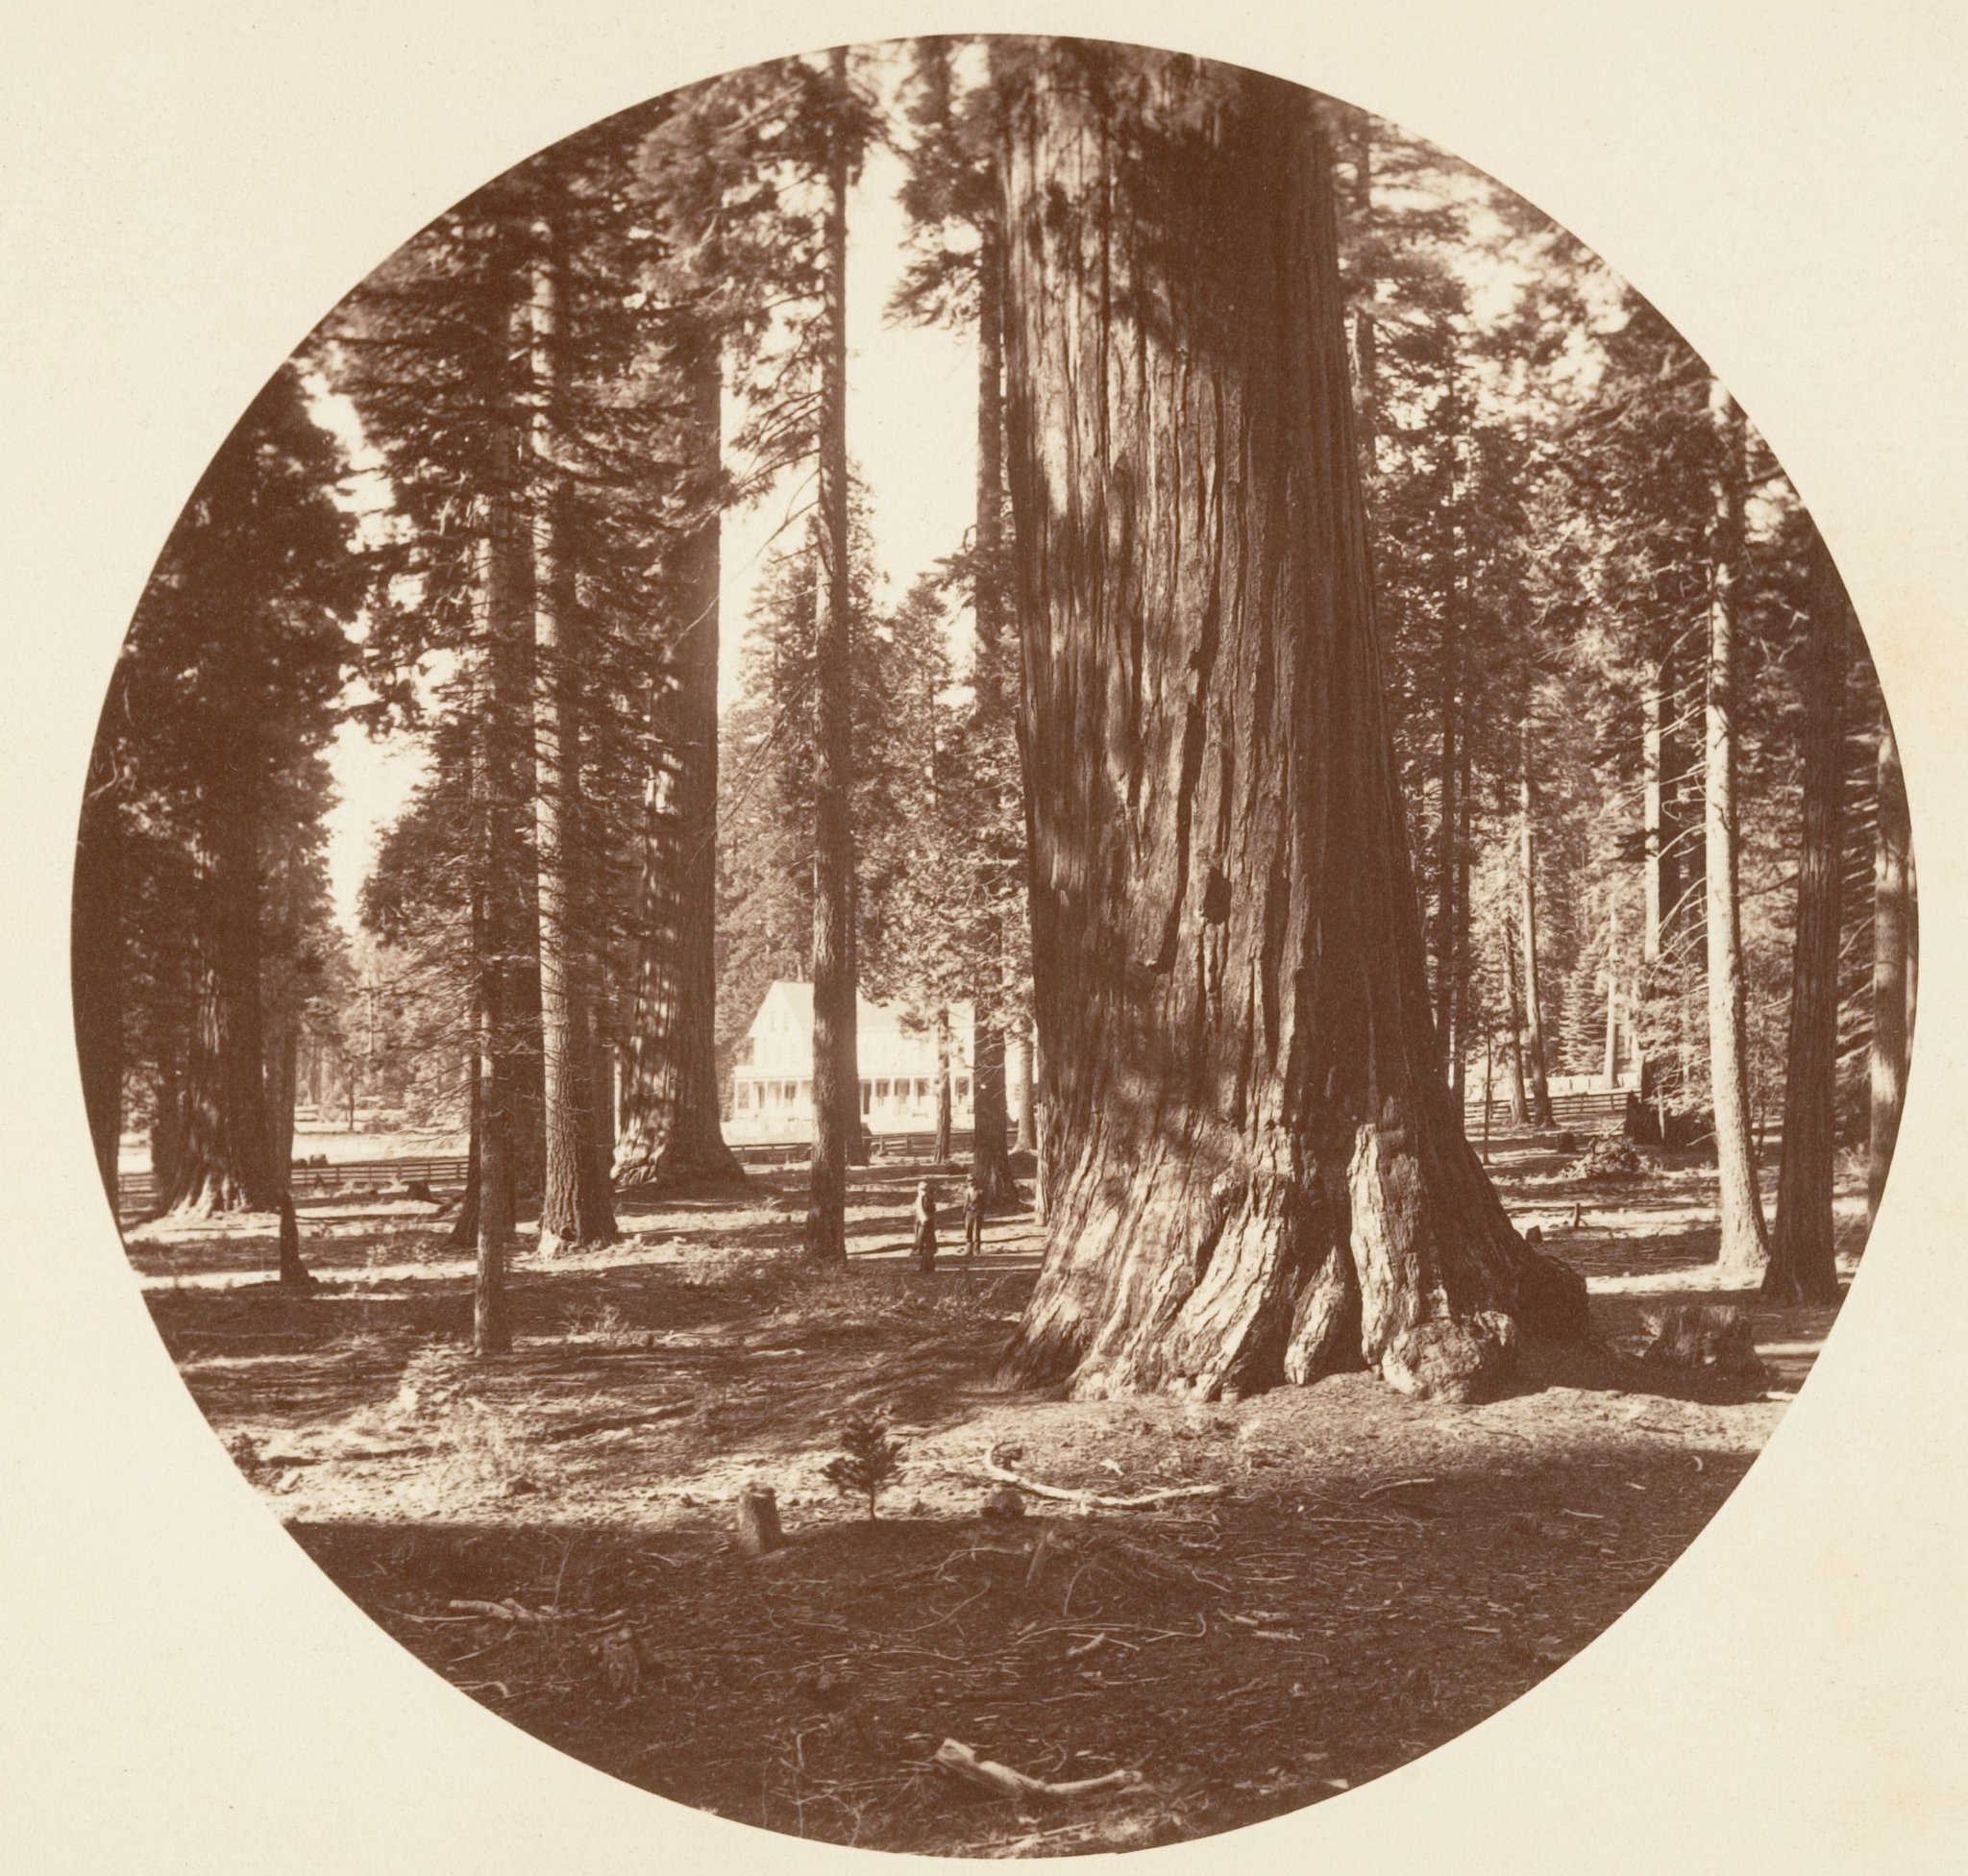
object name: photograph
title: The Mammoth Grove Hotel from the Grove - Calaveras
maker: carleton e. watkins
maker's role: artist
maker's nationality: american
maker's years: 1829-1916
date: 1878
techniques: albumen silver print, glass negative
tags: forests,trees